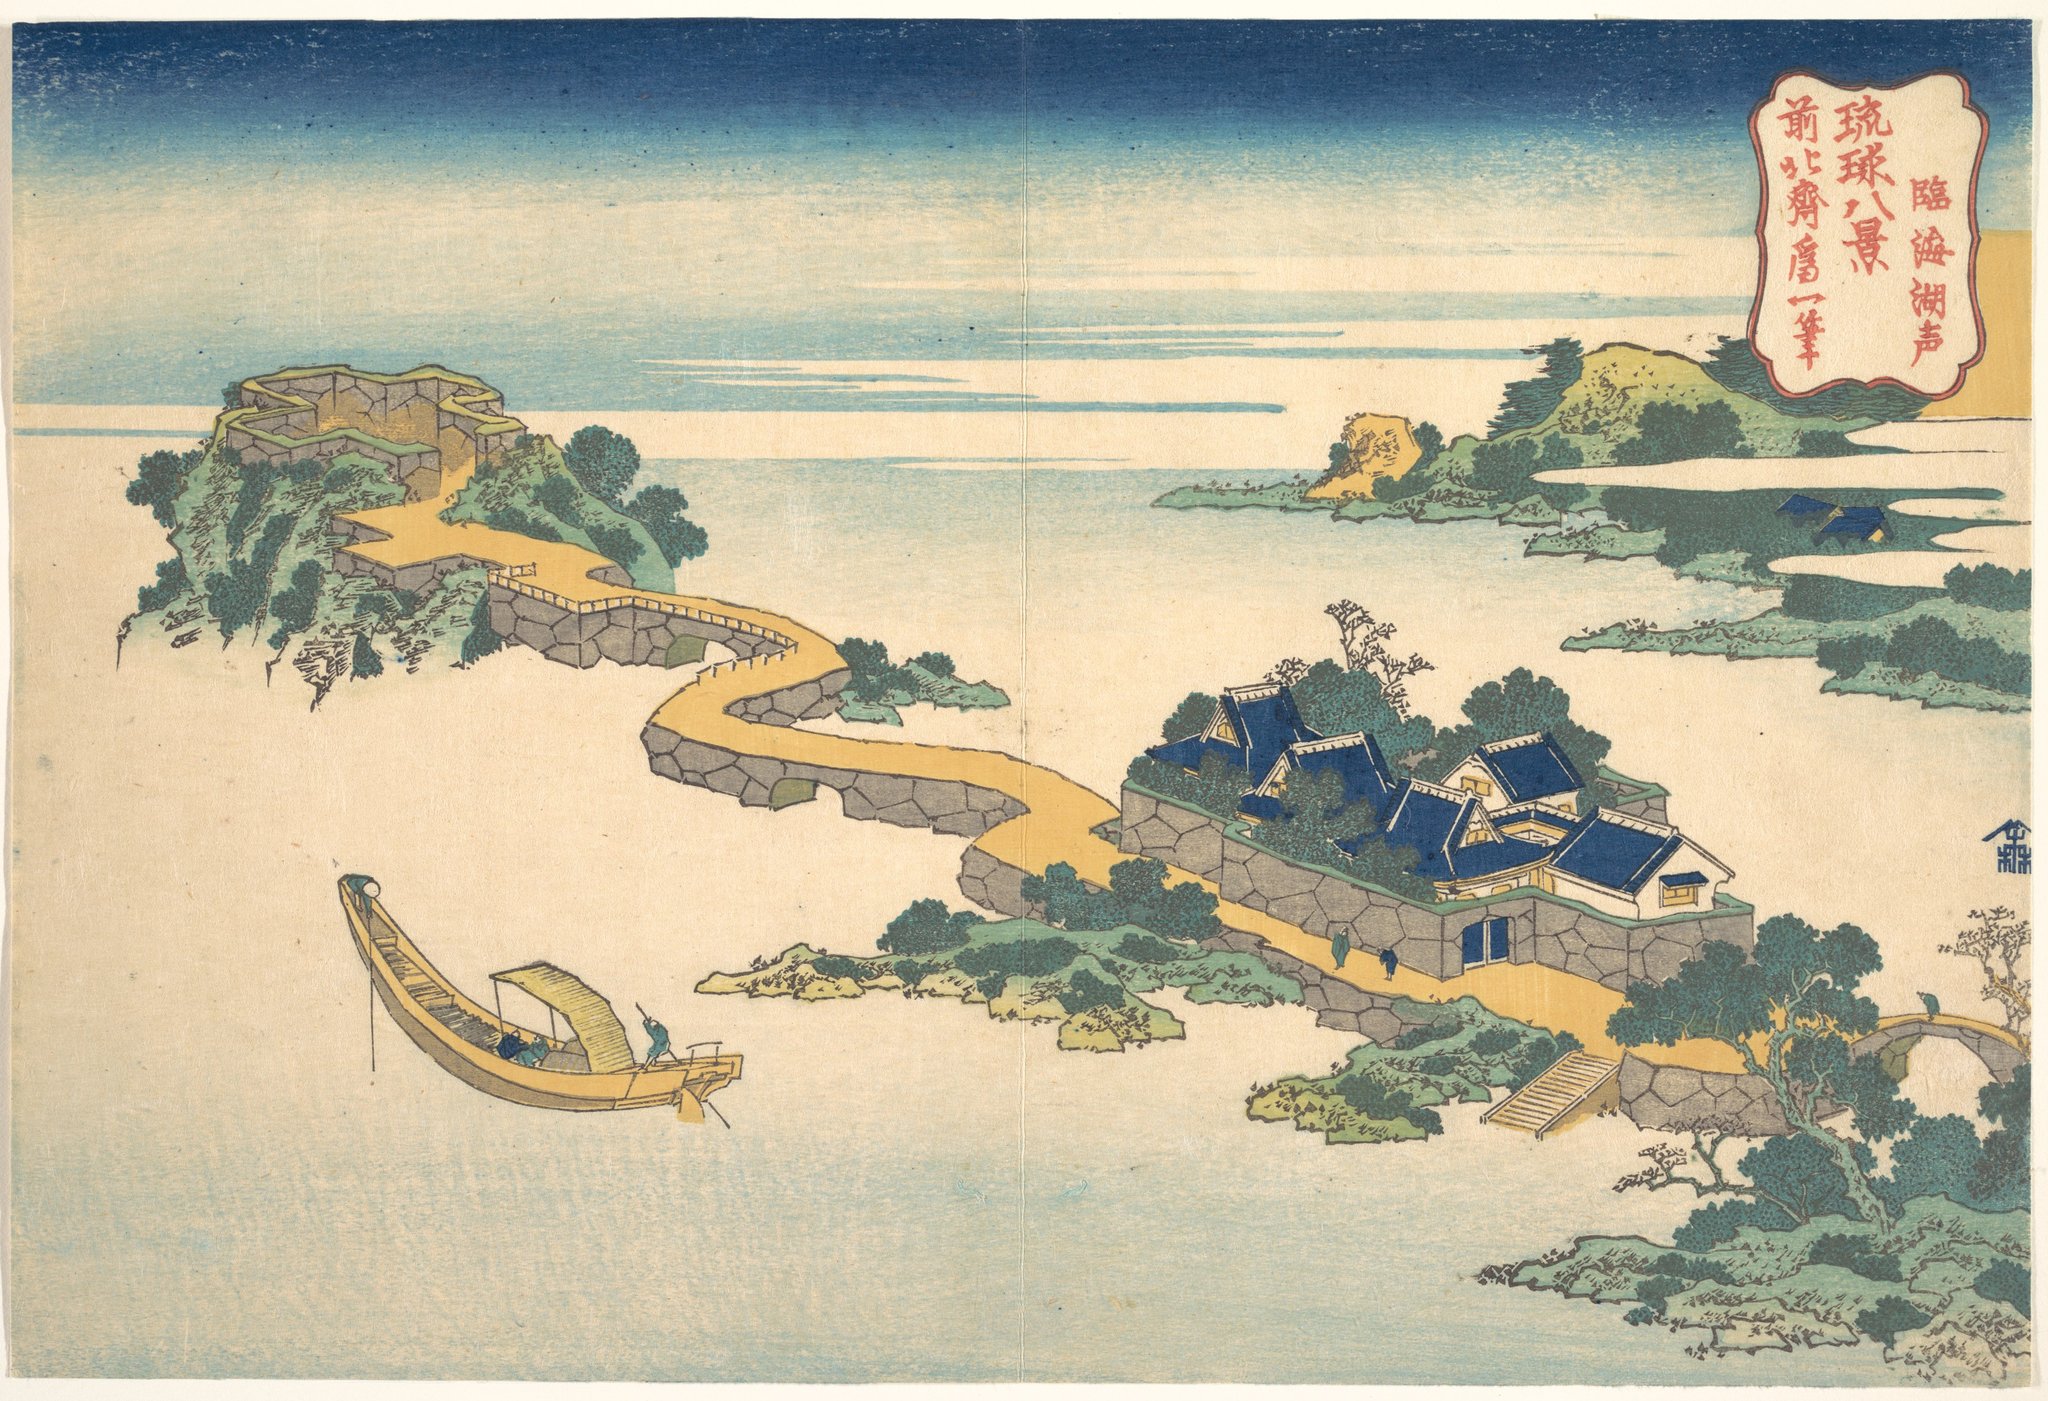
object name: woodblock print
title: Sound of the Lake at Rinkai (Rinkai kosei), from the series Eight Views of the Ryūkyū Islands (Ryūkyū hakkei)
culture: japanese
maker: katsushika hokusai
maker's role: artist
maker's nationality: japanese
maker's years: 1760-1849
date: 1832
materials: ink, paper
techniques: woodblock print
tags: houses,lakes,landscapes,boats